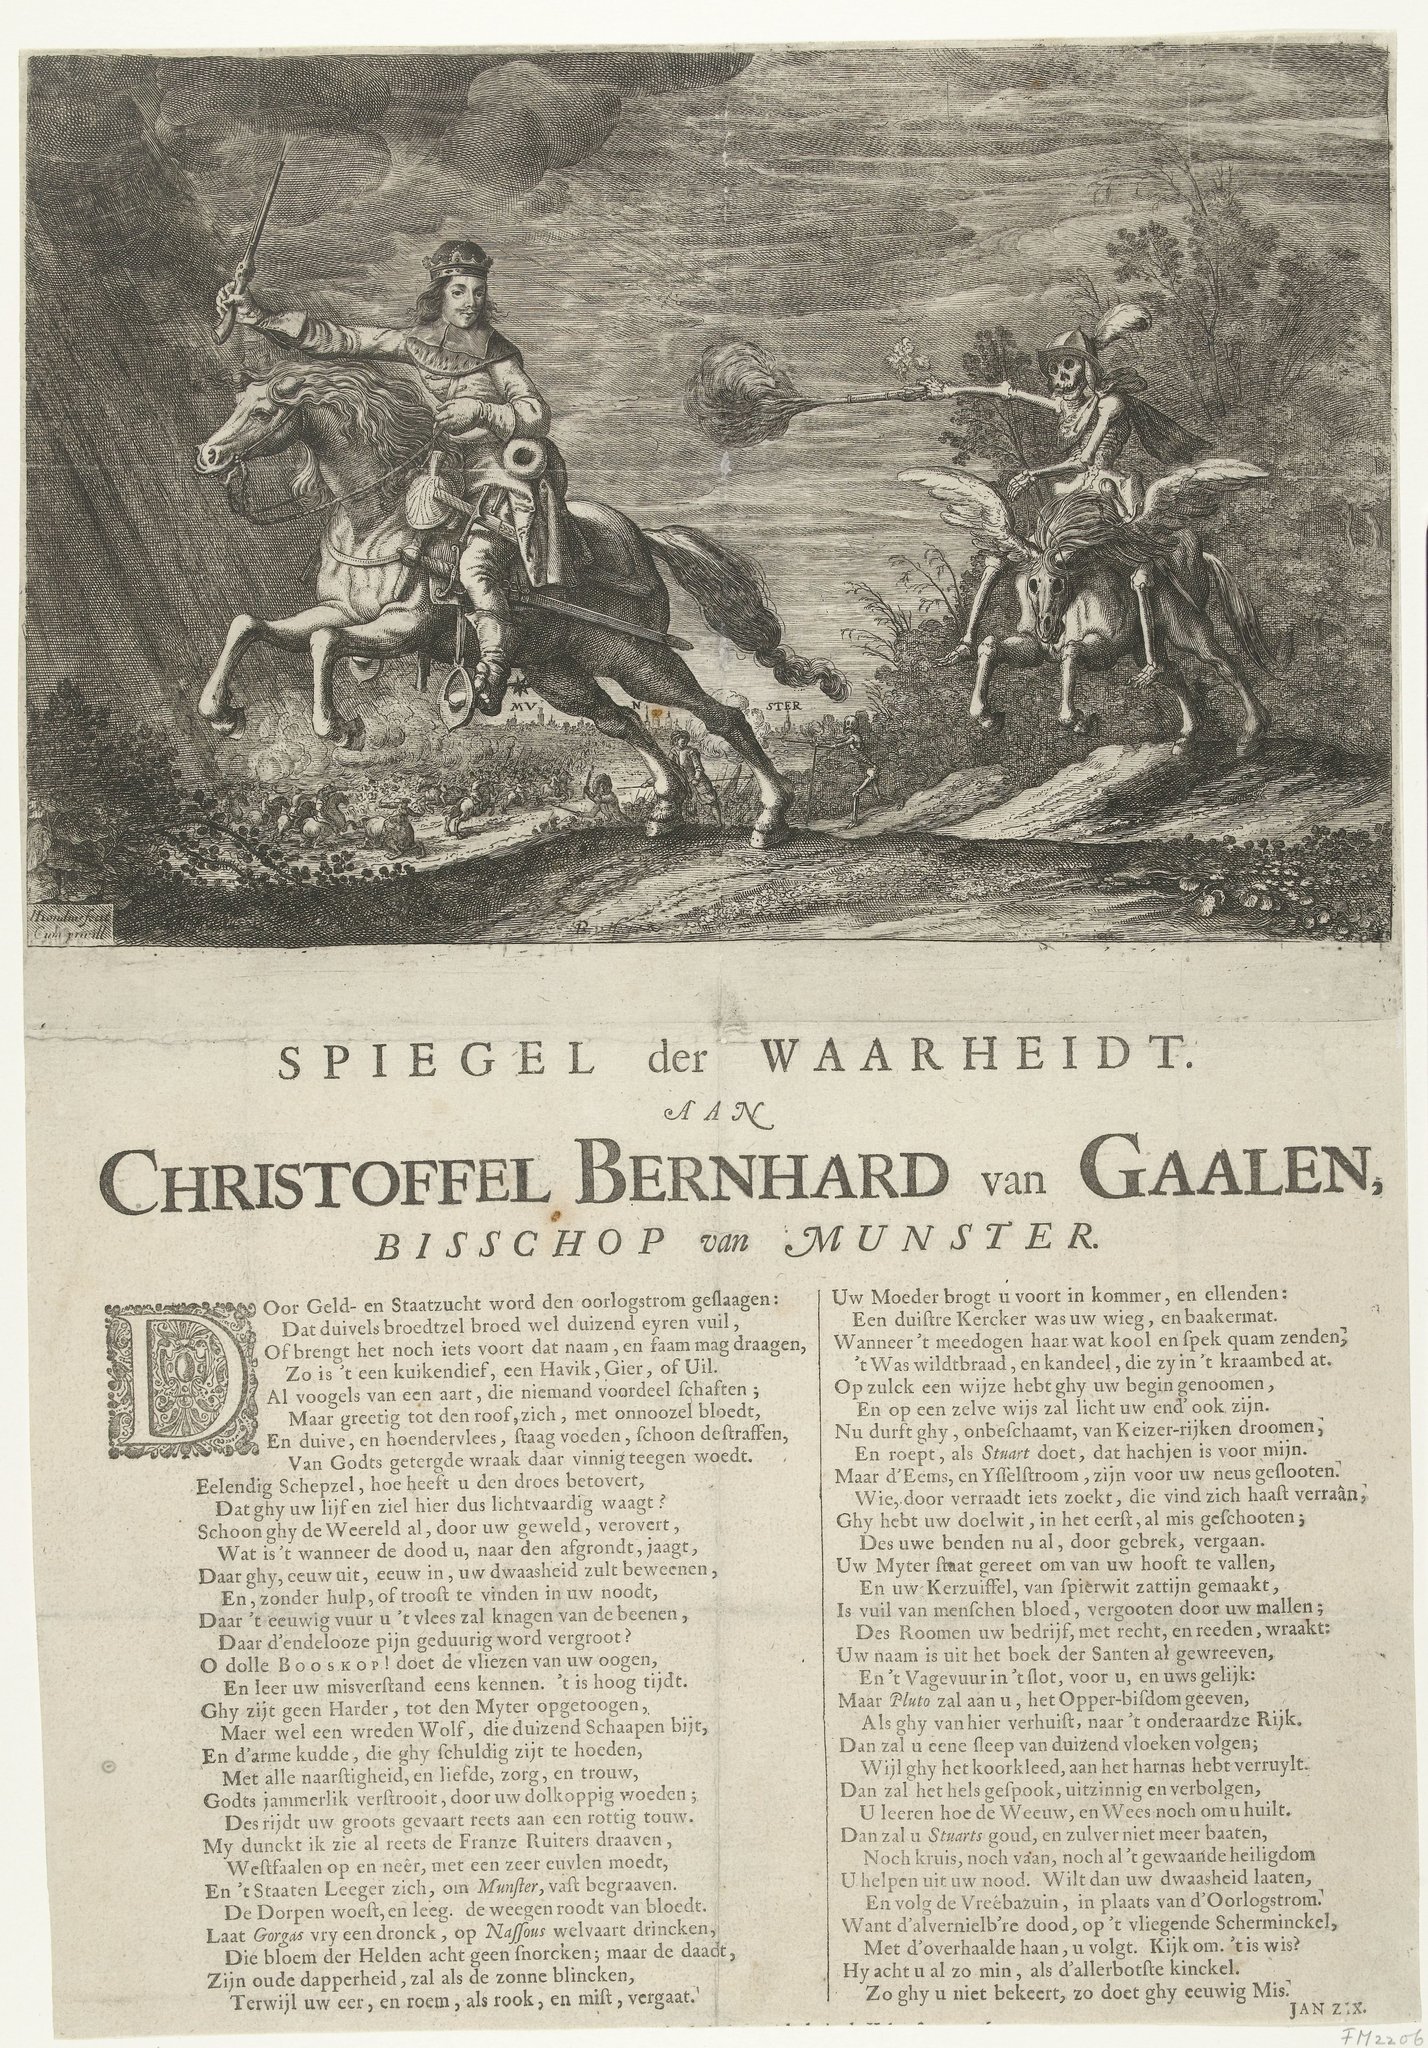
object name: cartoon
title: De bisschop van Munster achtervolgd door de Dood, 1665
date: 1644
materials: paper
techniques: engraving, etching, letterpress printing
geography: northern netherlands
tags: death as skeleton, flight, running away; pursuing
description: Christoph Bernard von Galen, de bisschop van Munster, te paard achtervolgd door de Dood, beiden gewapend met pistolen. Spotprent op de bisschop bij het uitbreken van de Tweede Engelse Oorlog. Op de achtergrond gevechten voor de stad Munster. Onder de plaat gedrukt op het blad een vers in twee kolommen.